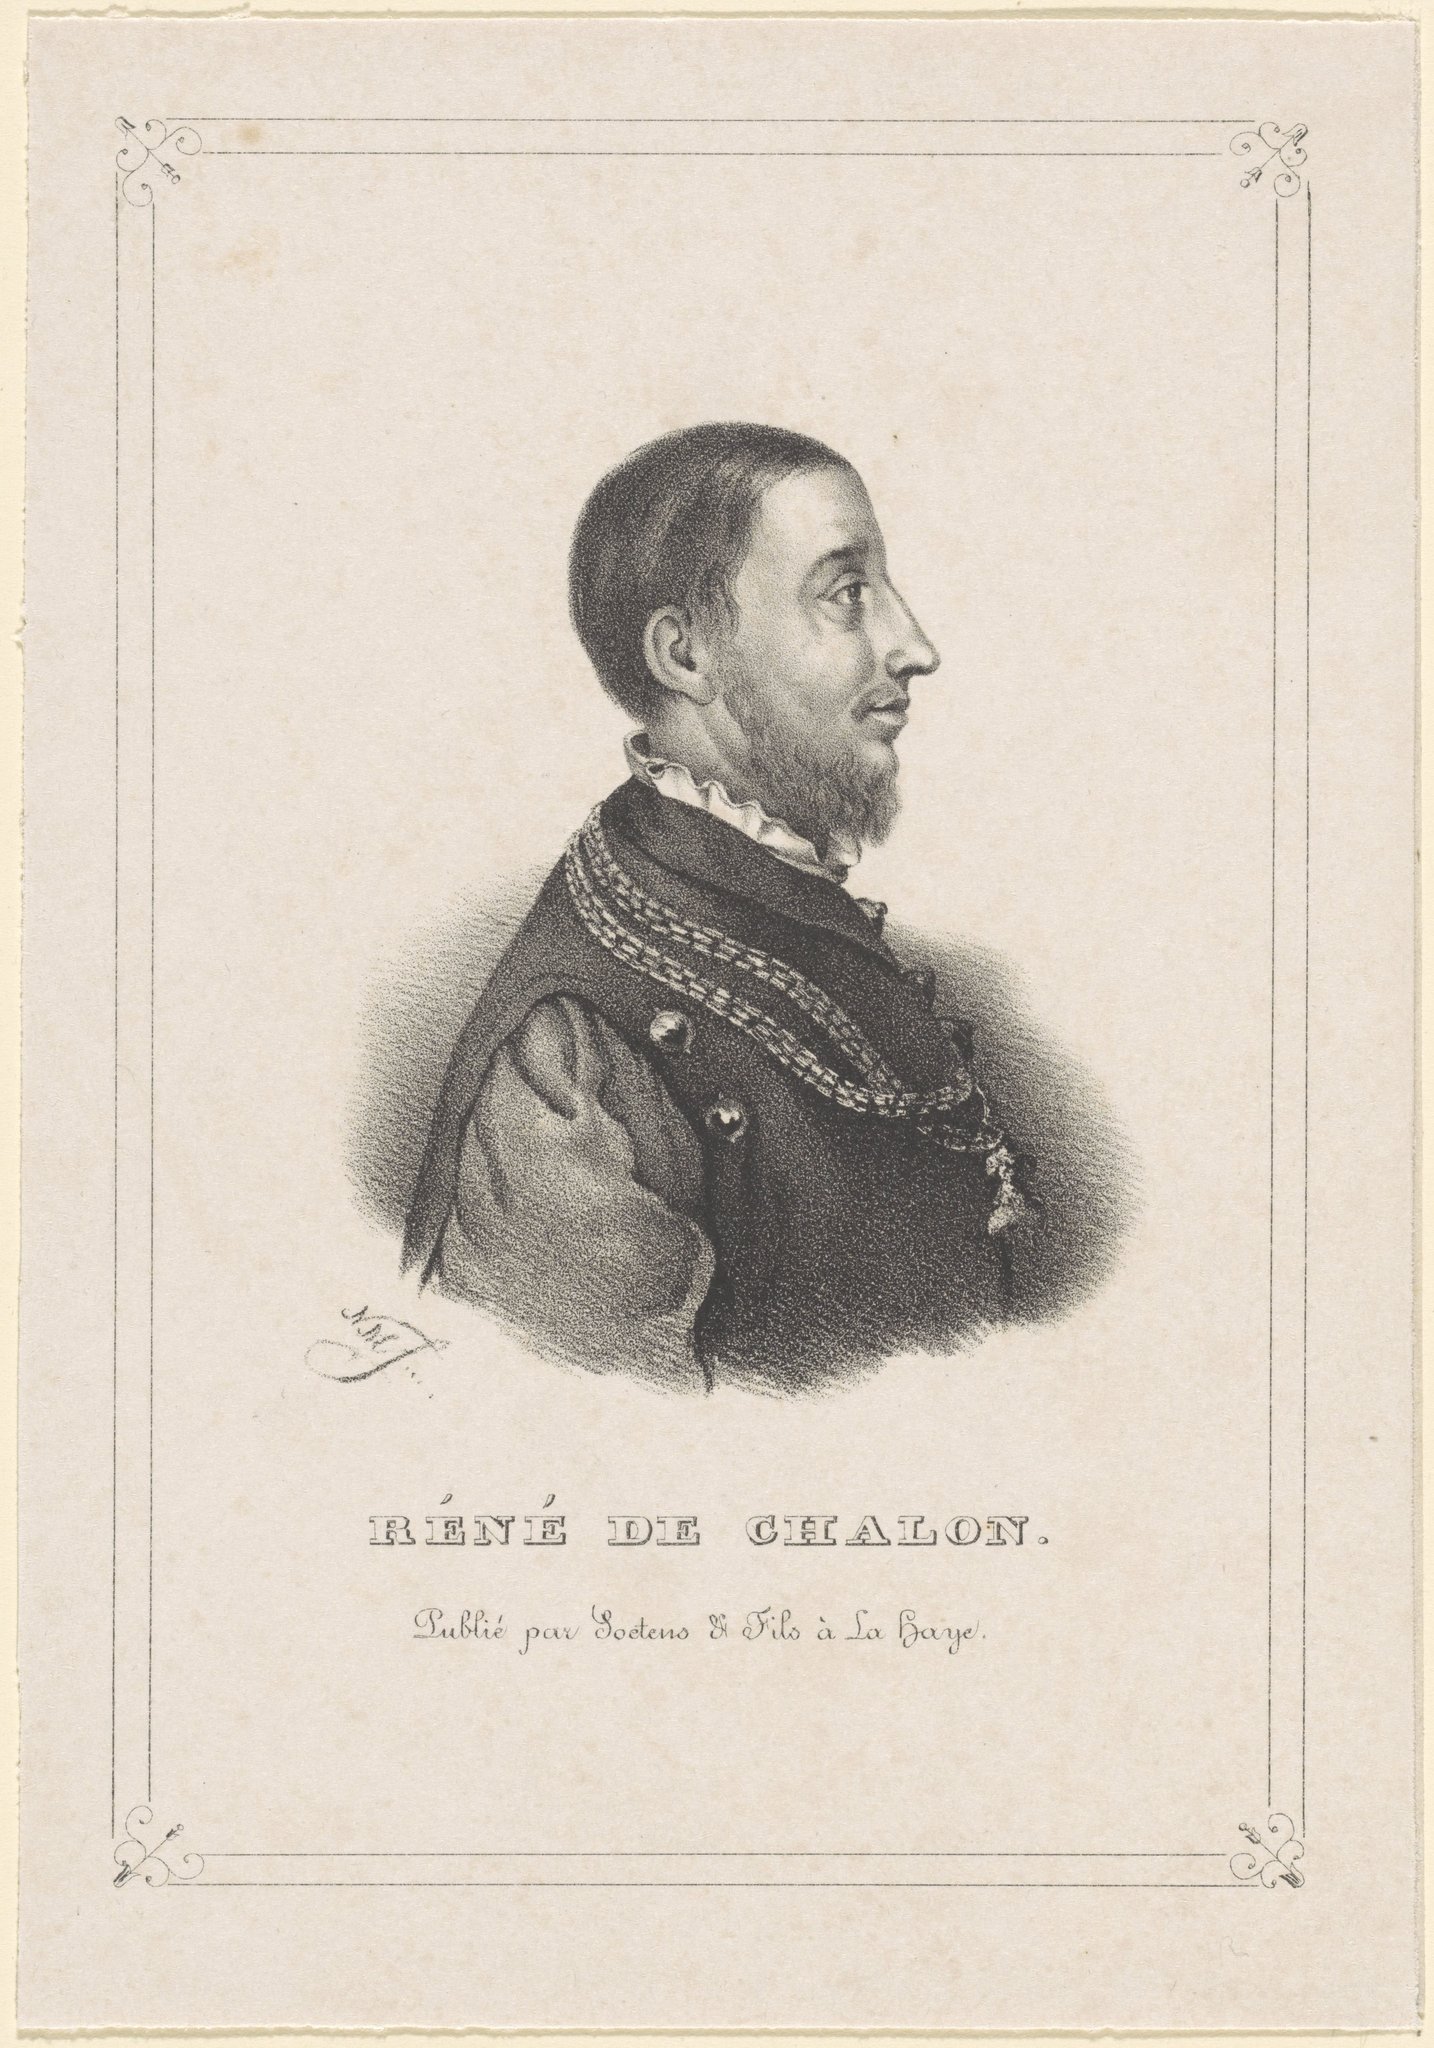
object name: print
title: Portret van René van Châlon, prins van Oranje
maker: nicolaas martinus schild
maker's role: draughtsman, print maker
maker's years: 1822-1840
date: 1837-1840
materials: paper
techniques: lithograph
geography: netherlands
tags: knighthood order of the golden fleece - insignia of a knighthood order, e.g.: badge, chain (with name of order)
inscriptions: collector's mark: Lugt 963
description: De hier vermelde titel verwijst naar de hoogst verkregen titel van de geportretteerde, niet per se naar de titel die de geportretteerde op deze voorstelling draagt.